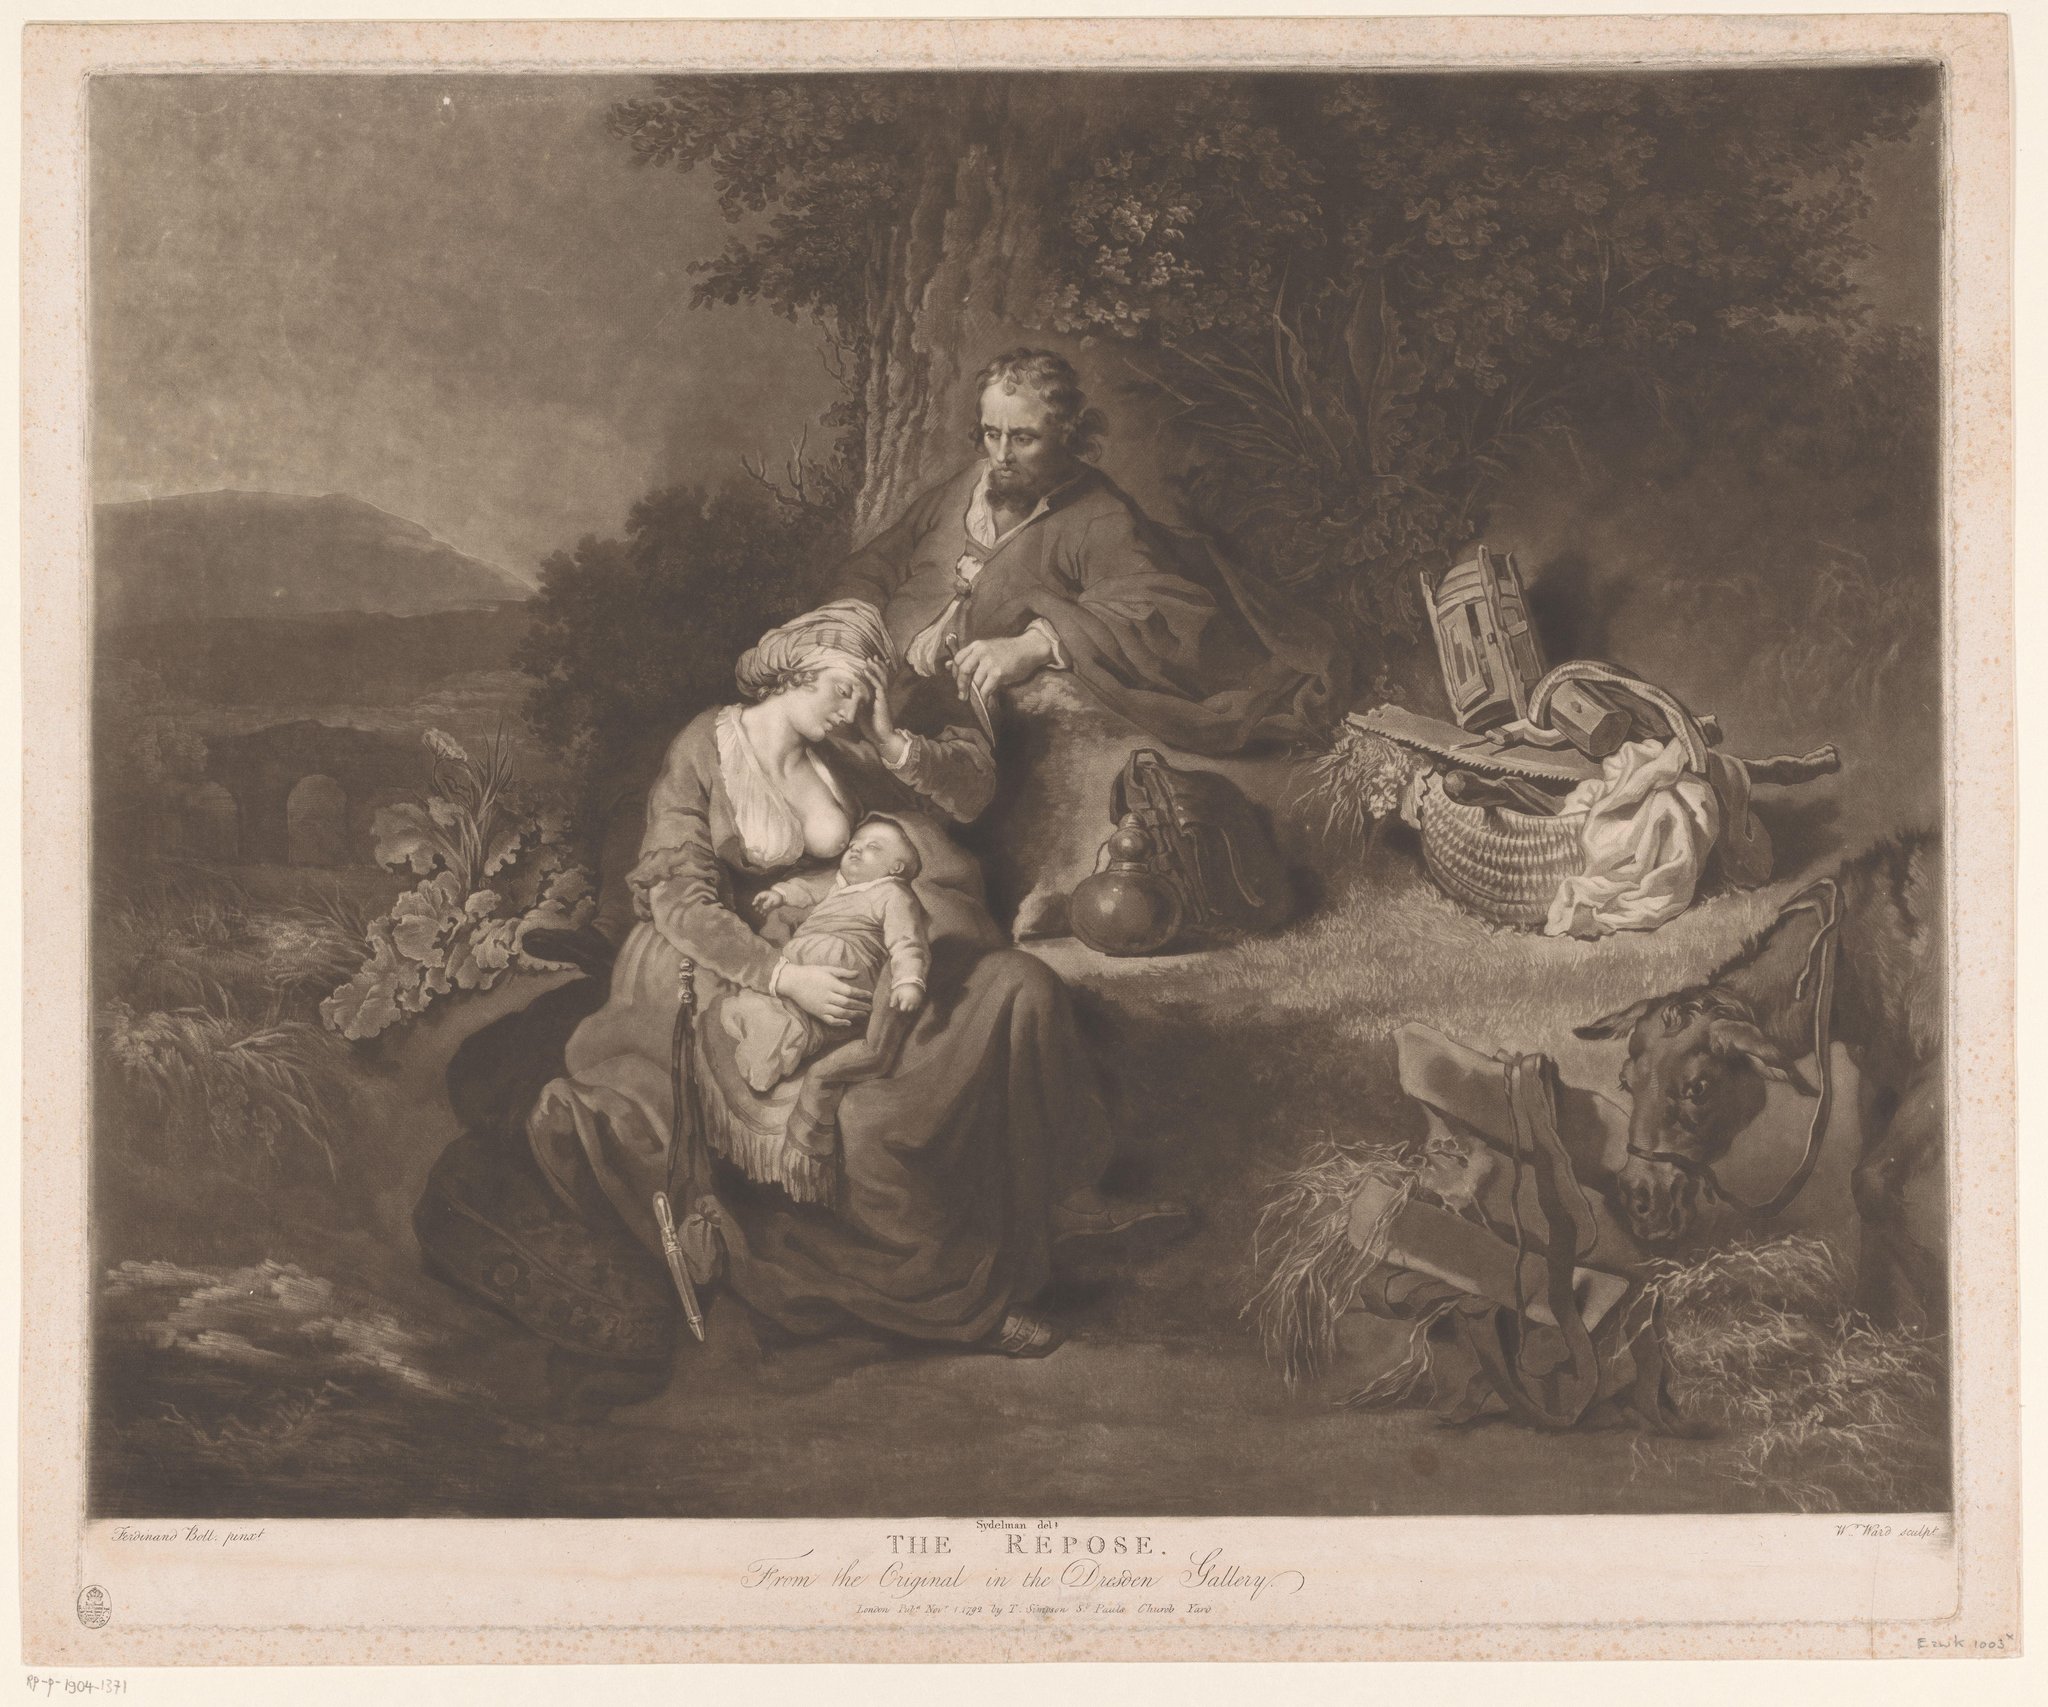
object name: print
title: Rest on the Flight into Egypt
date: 1792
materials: paper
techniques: mezzotint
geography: london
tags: breasts giving milk, rest on the flight into egypt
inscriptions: collector's mark: Lugt 1618, collector's mark: Lugt 2228, collector's mark: Lugt 1647